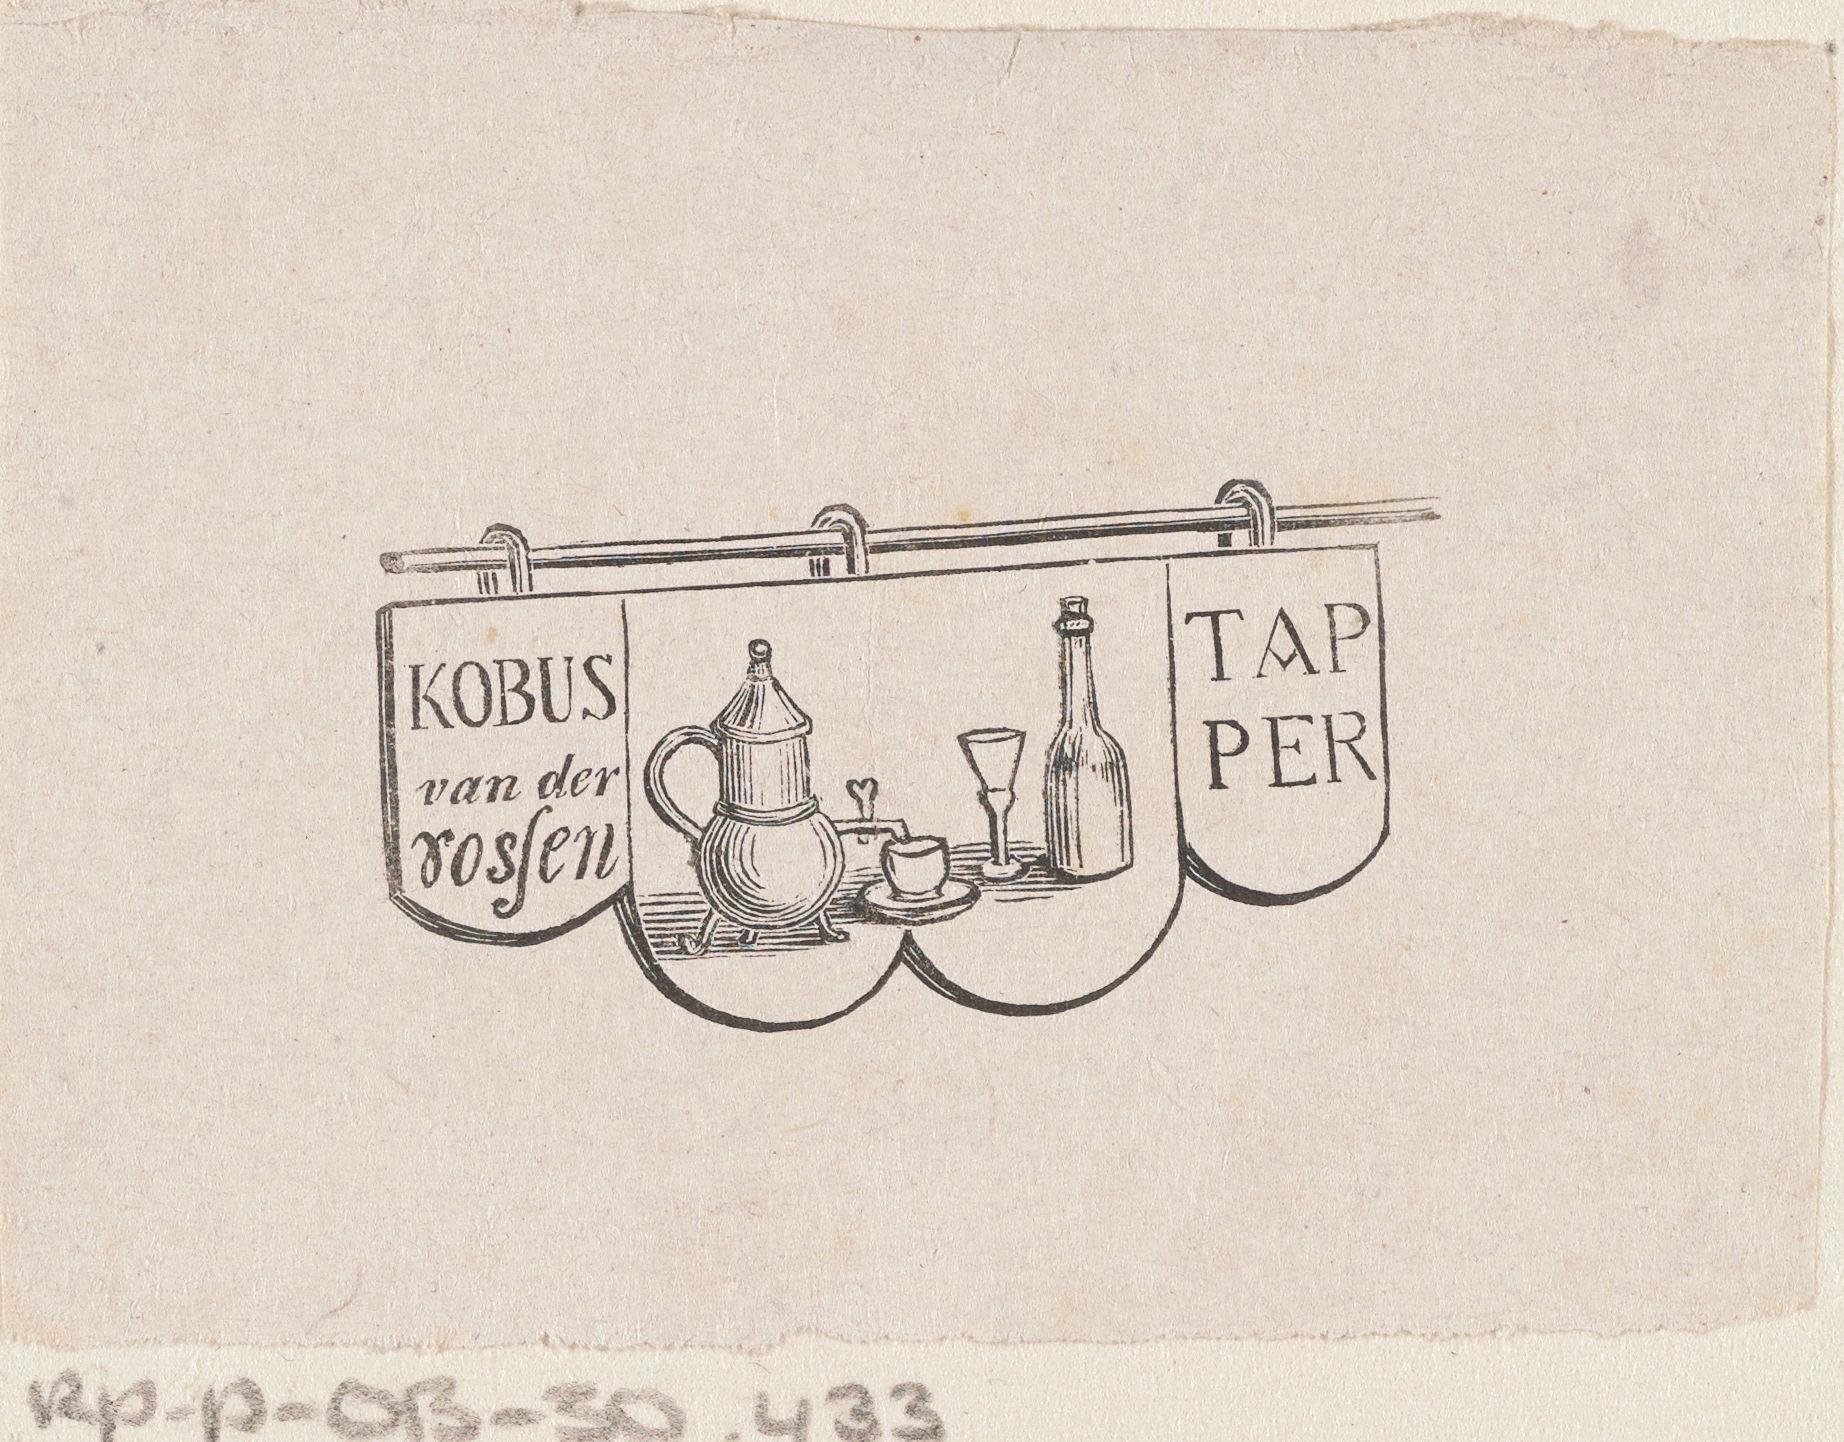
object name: print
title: Vignet met een uithangbord van een café met daarop een kan, een kop, een fles en een glas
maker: isaac weissenbruch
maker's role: print maker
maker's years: 1826-1912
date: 1836-1912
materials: paper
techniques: engraving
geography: netherlands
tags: containers, inn, coffee-house, public house, etc., drinking-vessels, signboard, vignette